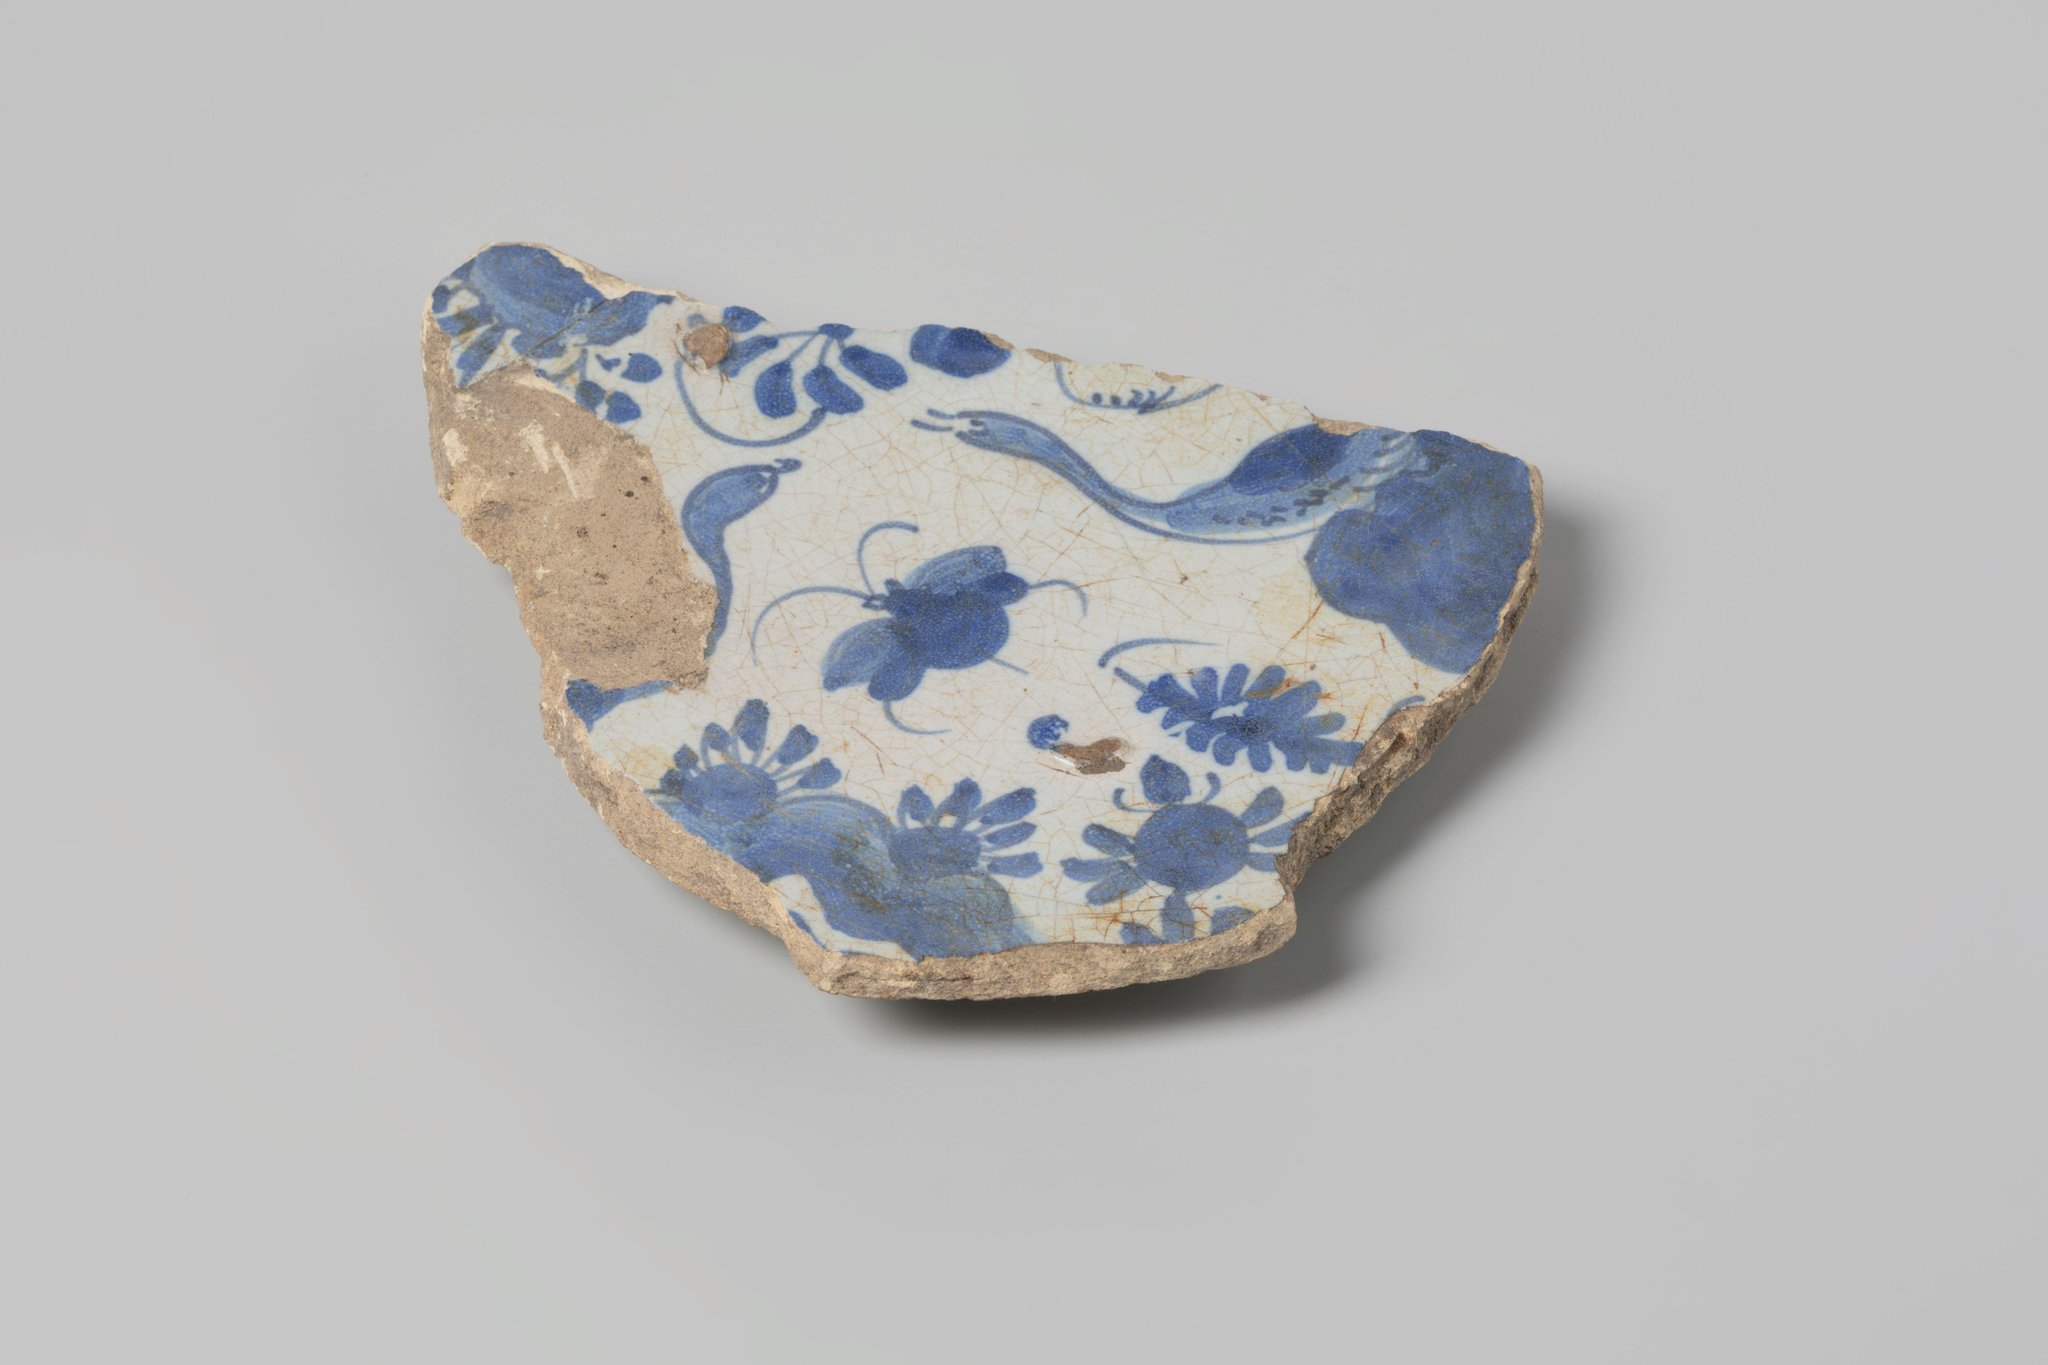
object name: sherd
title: Schotelscherf van aardewerk met aan de achterzijde loodglazuur en aan de voorzijde tinglazuur en een decoratie van bloemen en dieren in blauw, gemerkt aan onderzijde, beschadigd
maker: Anonymous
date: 1500-1799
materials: earthenware, glaze